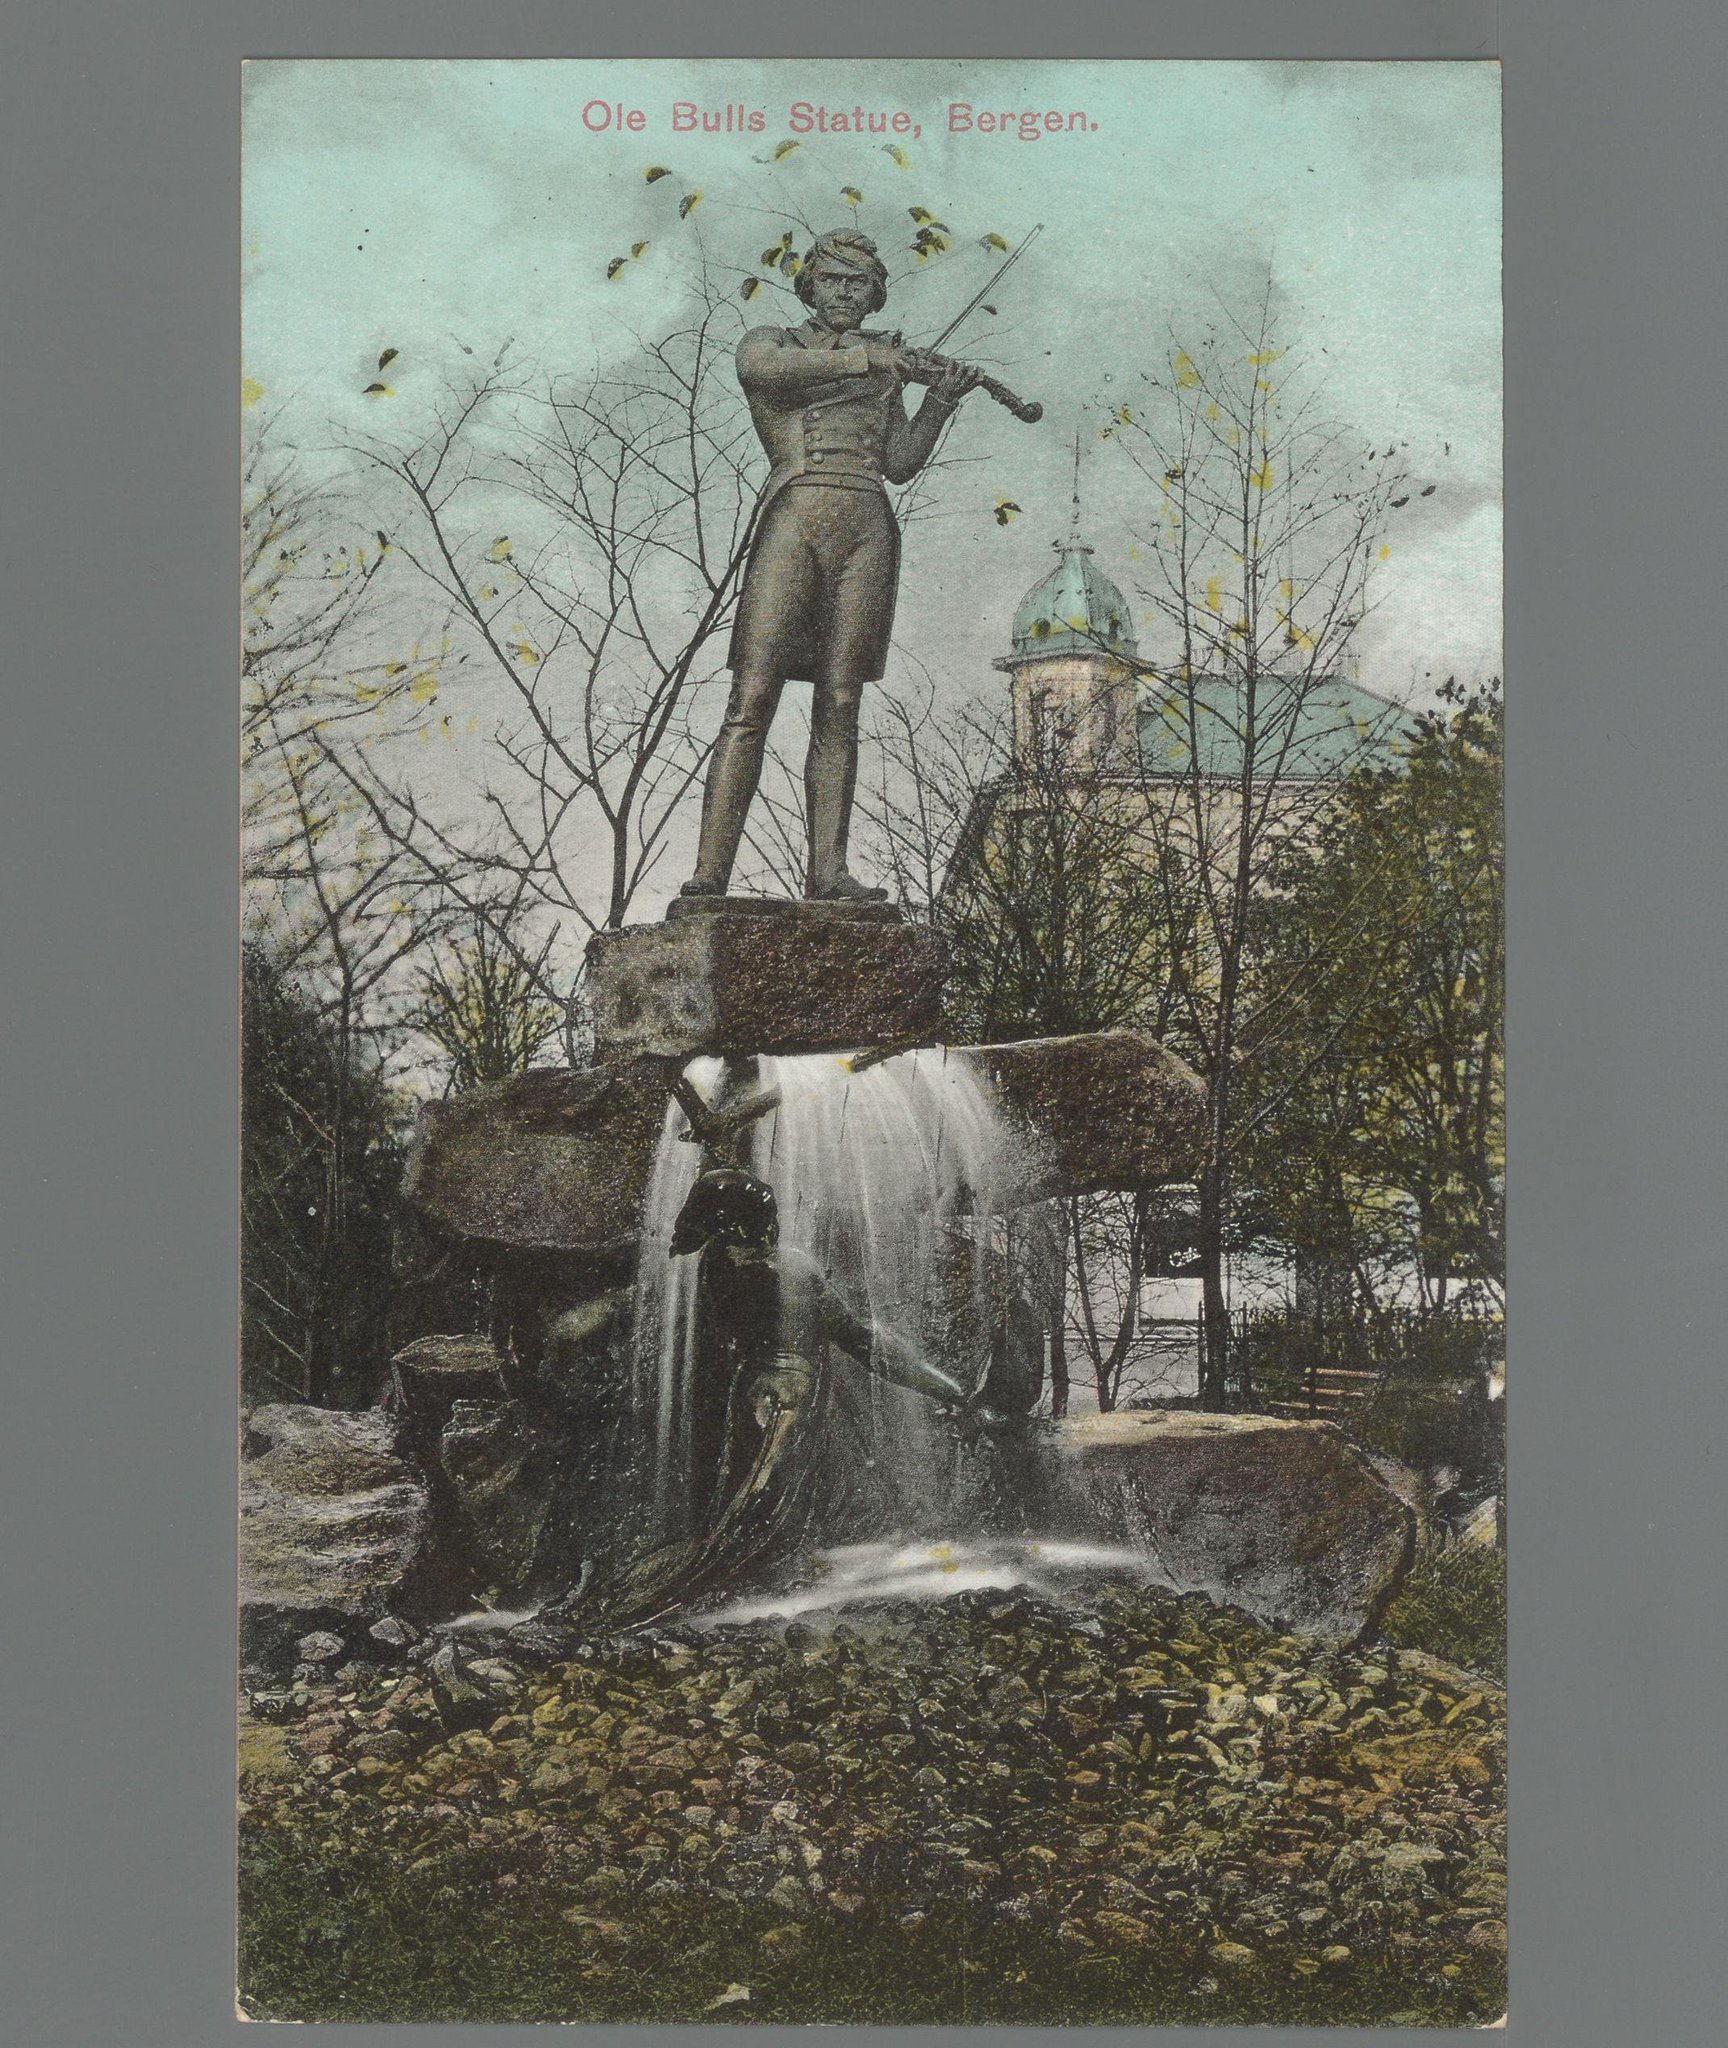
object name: photomechanical print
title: Ole Bulls Statue, Bergen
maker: Anonymous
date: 1904-1930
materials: cardboard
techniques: photograph, lithograph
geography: bergen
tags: monument, statue, ornamental fountain